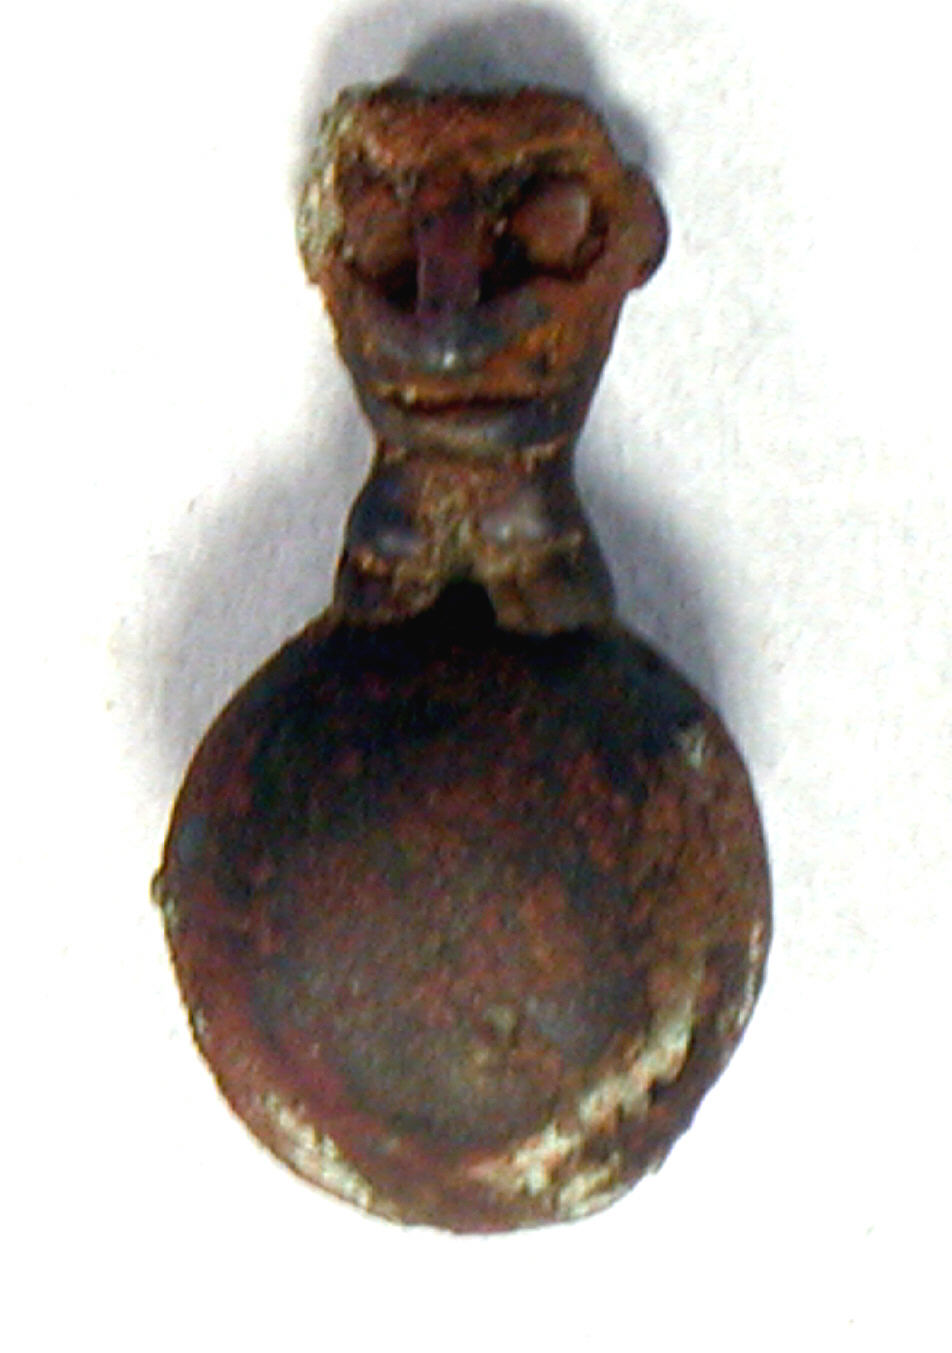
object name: bell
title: Copper Bell with Head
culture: peruvian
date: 1501-1600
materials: copper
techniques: casting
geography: peru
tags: musical instruments,heads